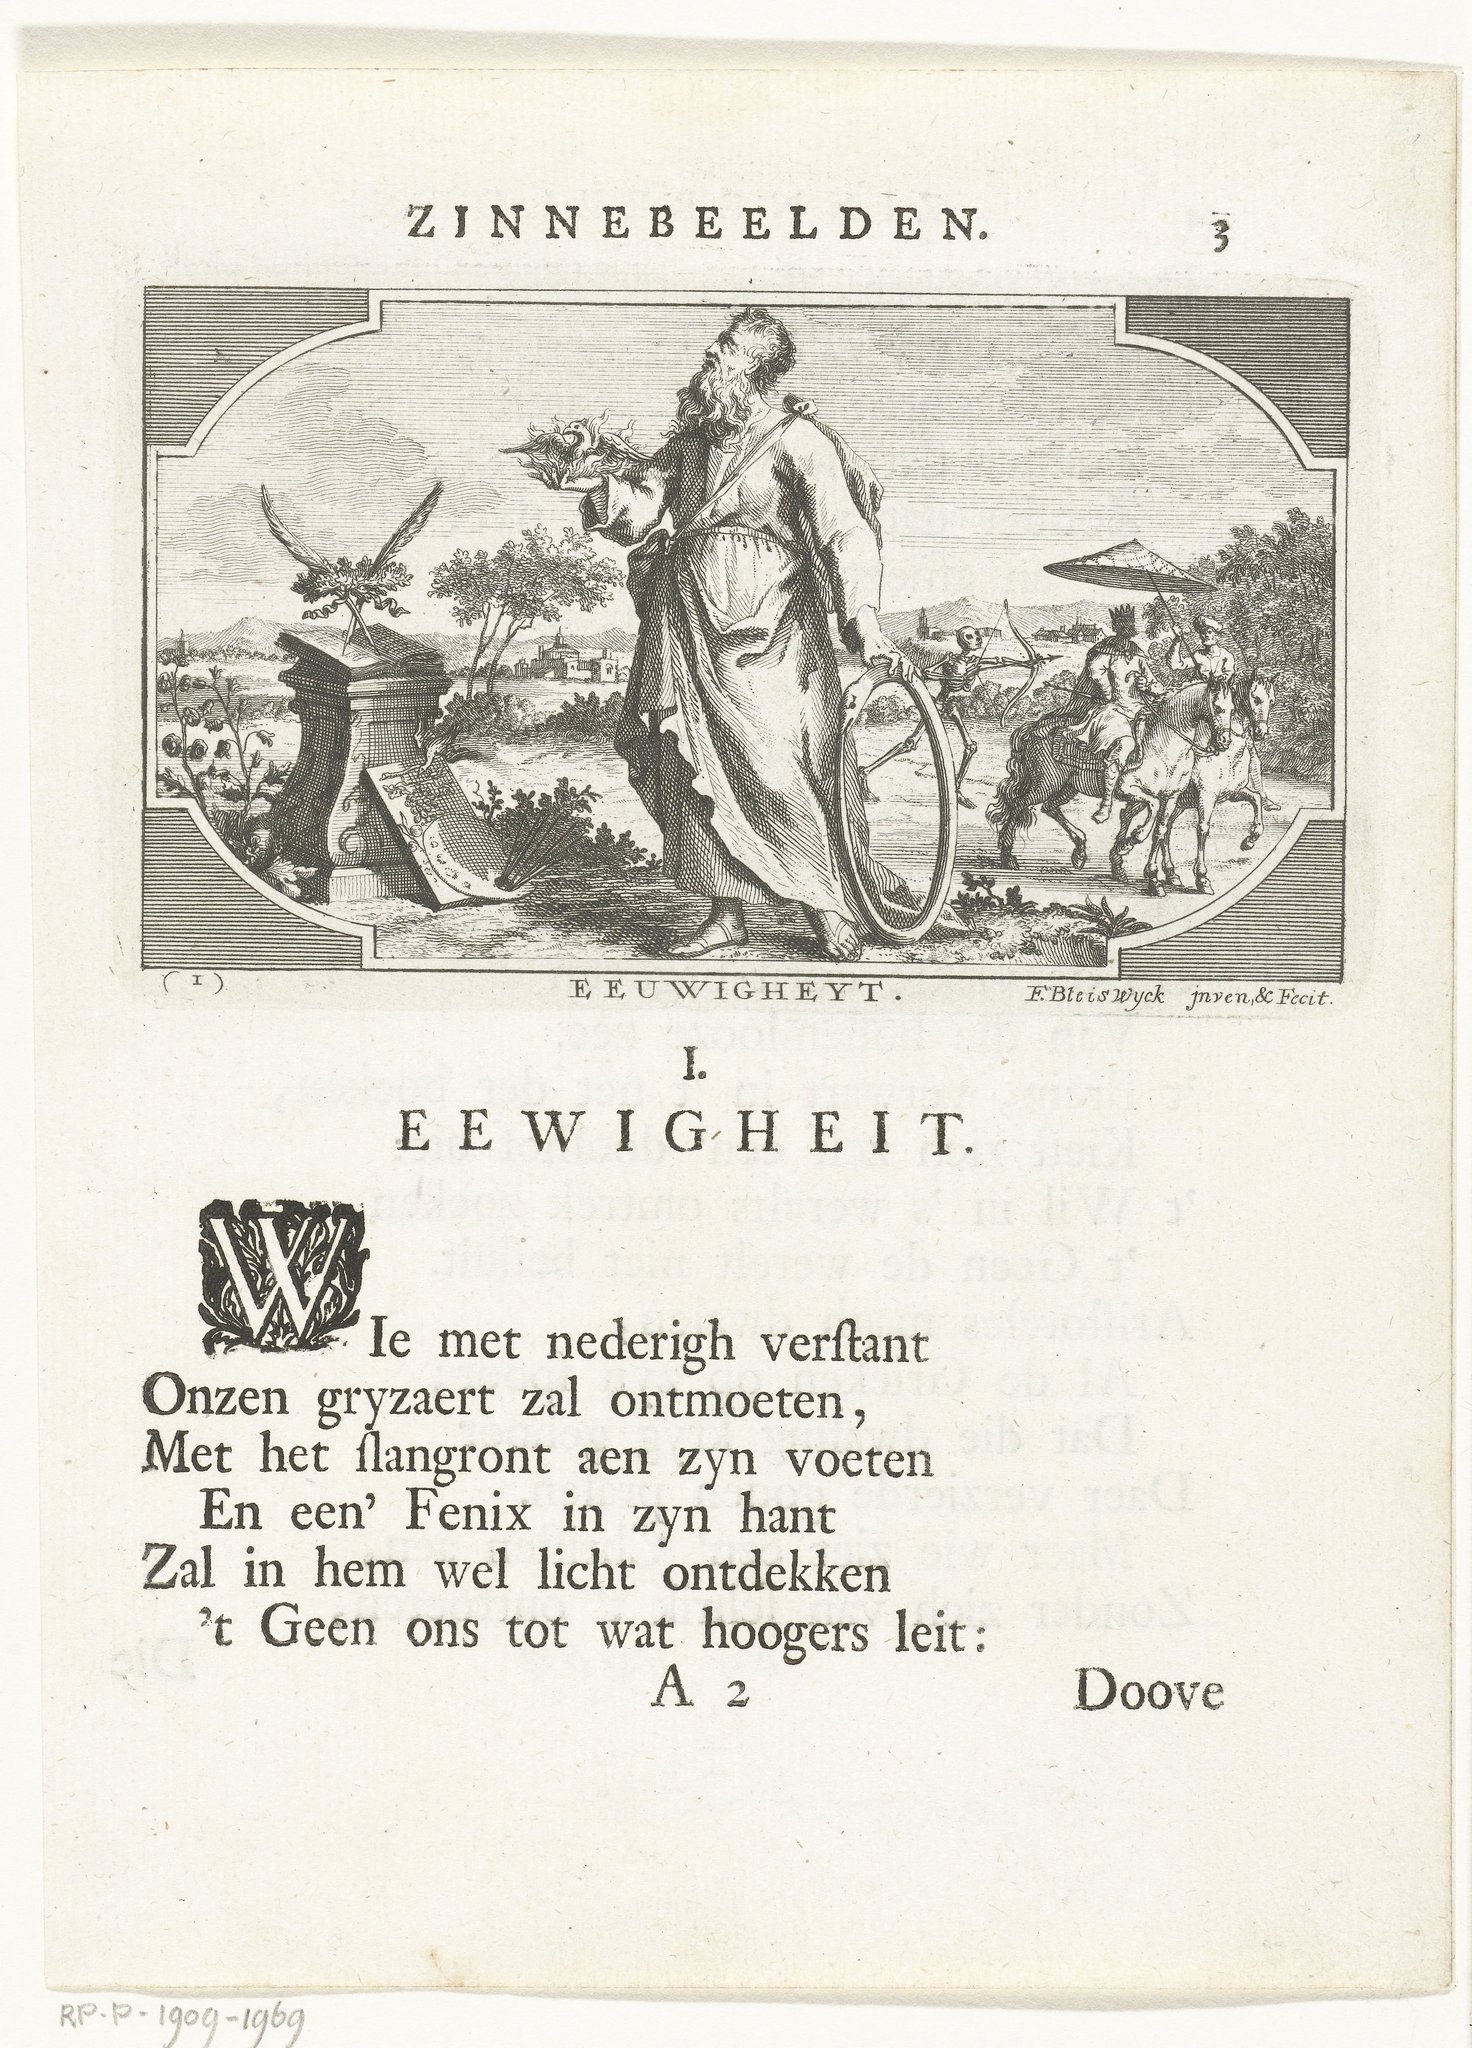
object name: print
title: Eeuwigheyt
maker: françois van bleyswijck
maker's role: draughtsman, print maker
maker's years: 1671-1746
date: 1681-1737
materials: paper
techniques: engraving, etching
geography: leiden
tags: eternity, 'aeternitas'; 'eternità','eternità o perpetuità' (ripa)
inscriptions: collector's mark: Lugt 2228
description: Embleem met allegorie op eeuwigheid verbeeld als Vadertje Tijd met slang in een ring (staart in bek) en vuurvogel in zijn hand. In een landschap maakt de Dood jacht op een koning met bediende te paard. Onder de voorstelling en op verso staat een gedicht.